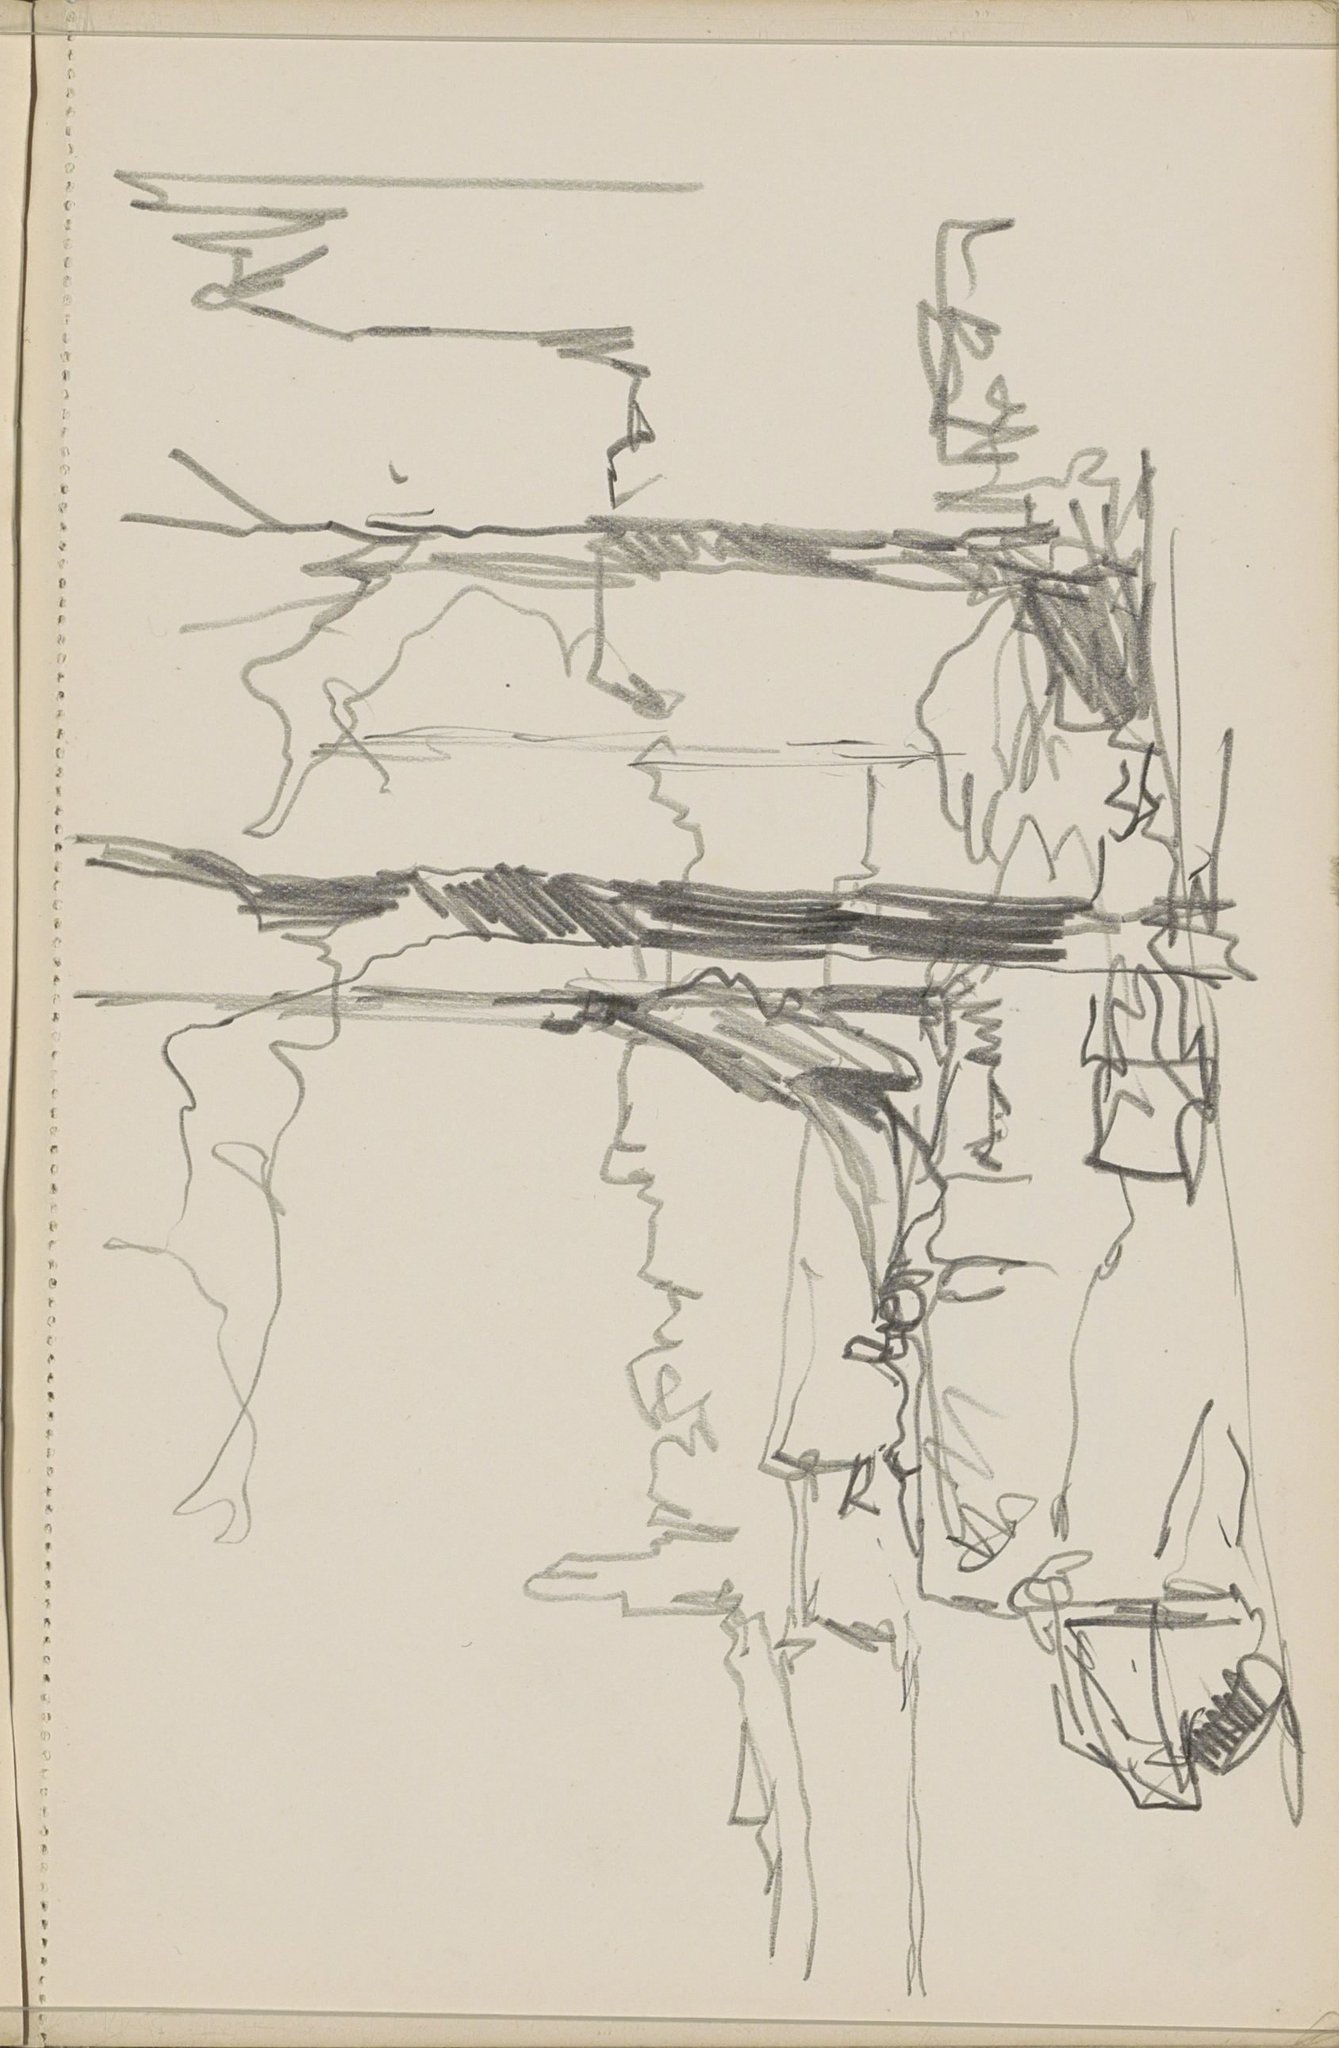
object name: sketchbook leaf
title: Aangemeerde zeilboten aan een kade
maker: cornelis vreedenburgh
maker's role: draughtsman, print maker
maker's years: 1880-1946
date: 1890-1946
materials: paper, pencil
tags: sailing-ship, sailing-boat, quay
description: Op de achtergrond huizen. Langs de kade een rij bomen. Blad 33 recto uit een schetsboek met 59 bladen.